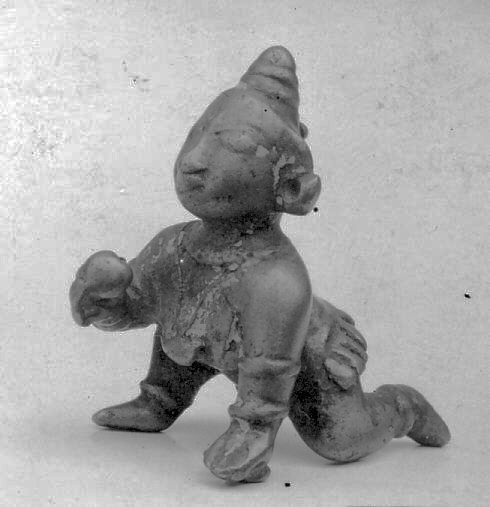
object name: portable idol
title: Krishna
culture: indian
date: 1701-1900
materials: brass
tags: krishna,hinduism